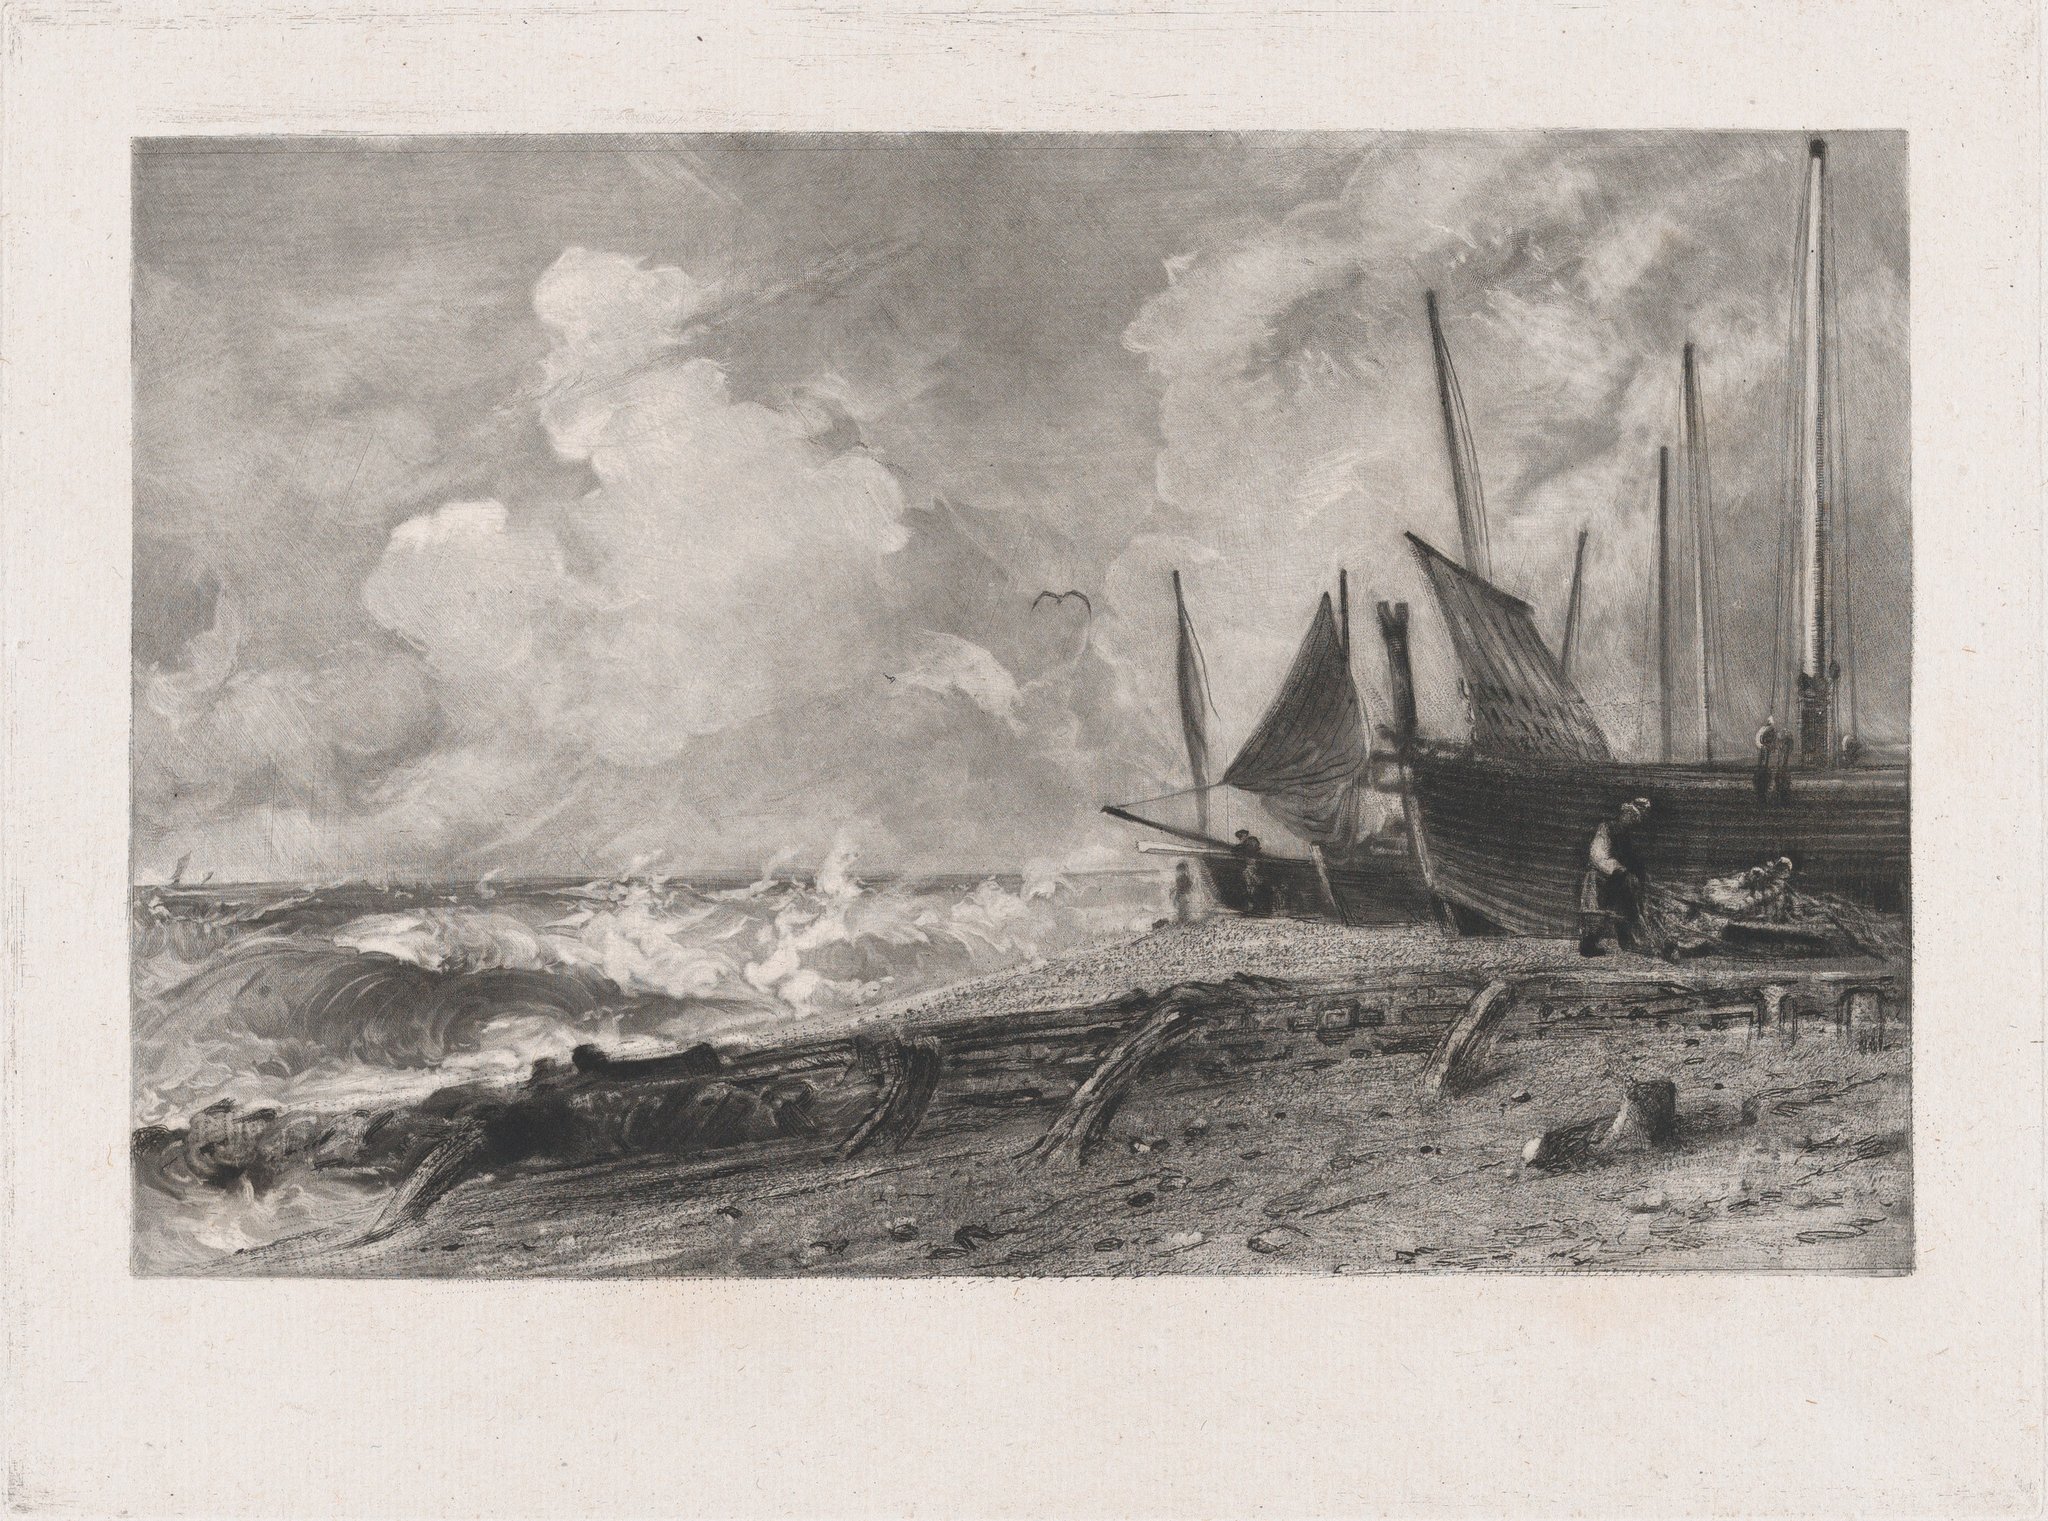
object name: print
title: A Sea Beach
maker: david lucas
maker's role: artist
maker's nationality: british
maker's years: 1802-1881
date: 1830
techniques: mezzotint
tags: boats